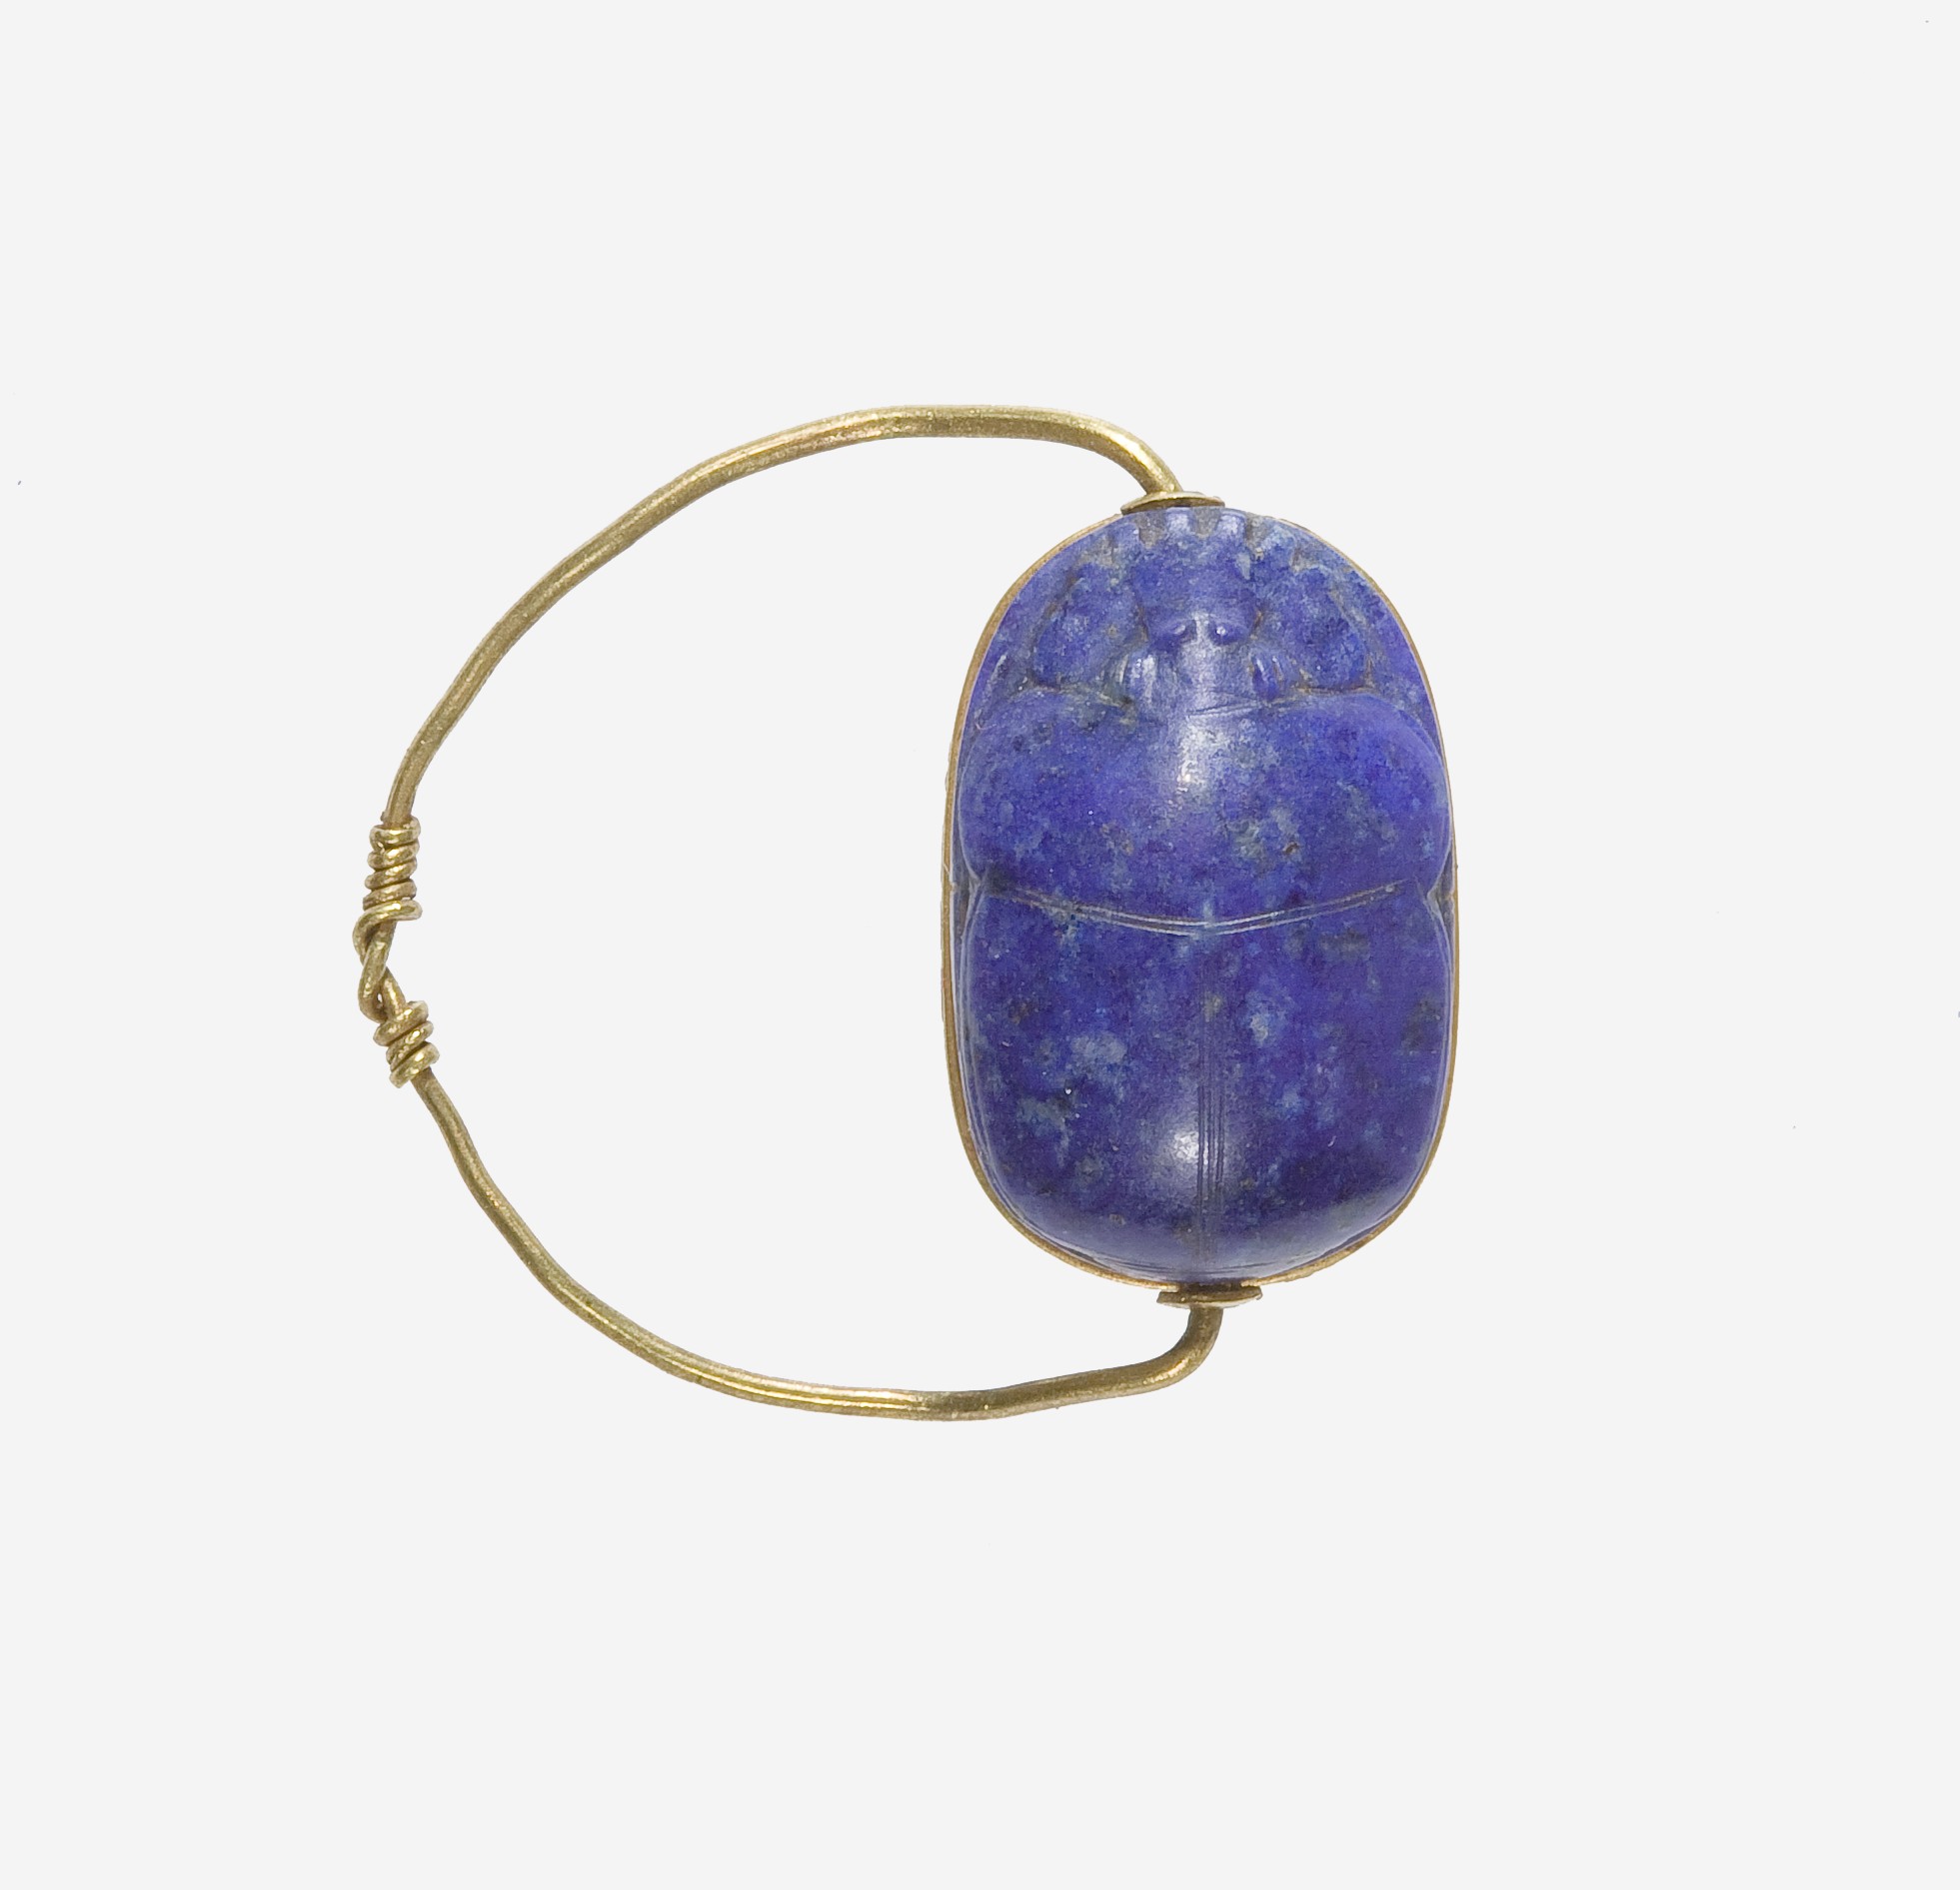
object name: ring with scarab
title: Scarab Finger Ring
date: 1850-1750 BCE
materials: gold, lapis lazuli, metal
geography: memphite region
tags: scarabs